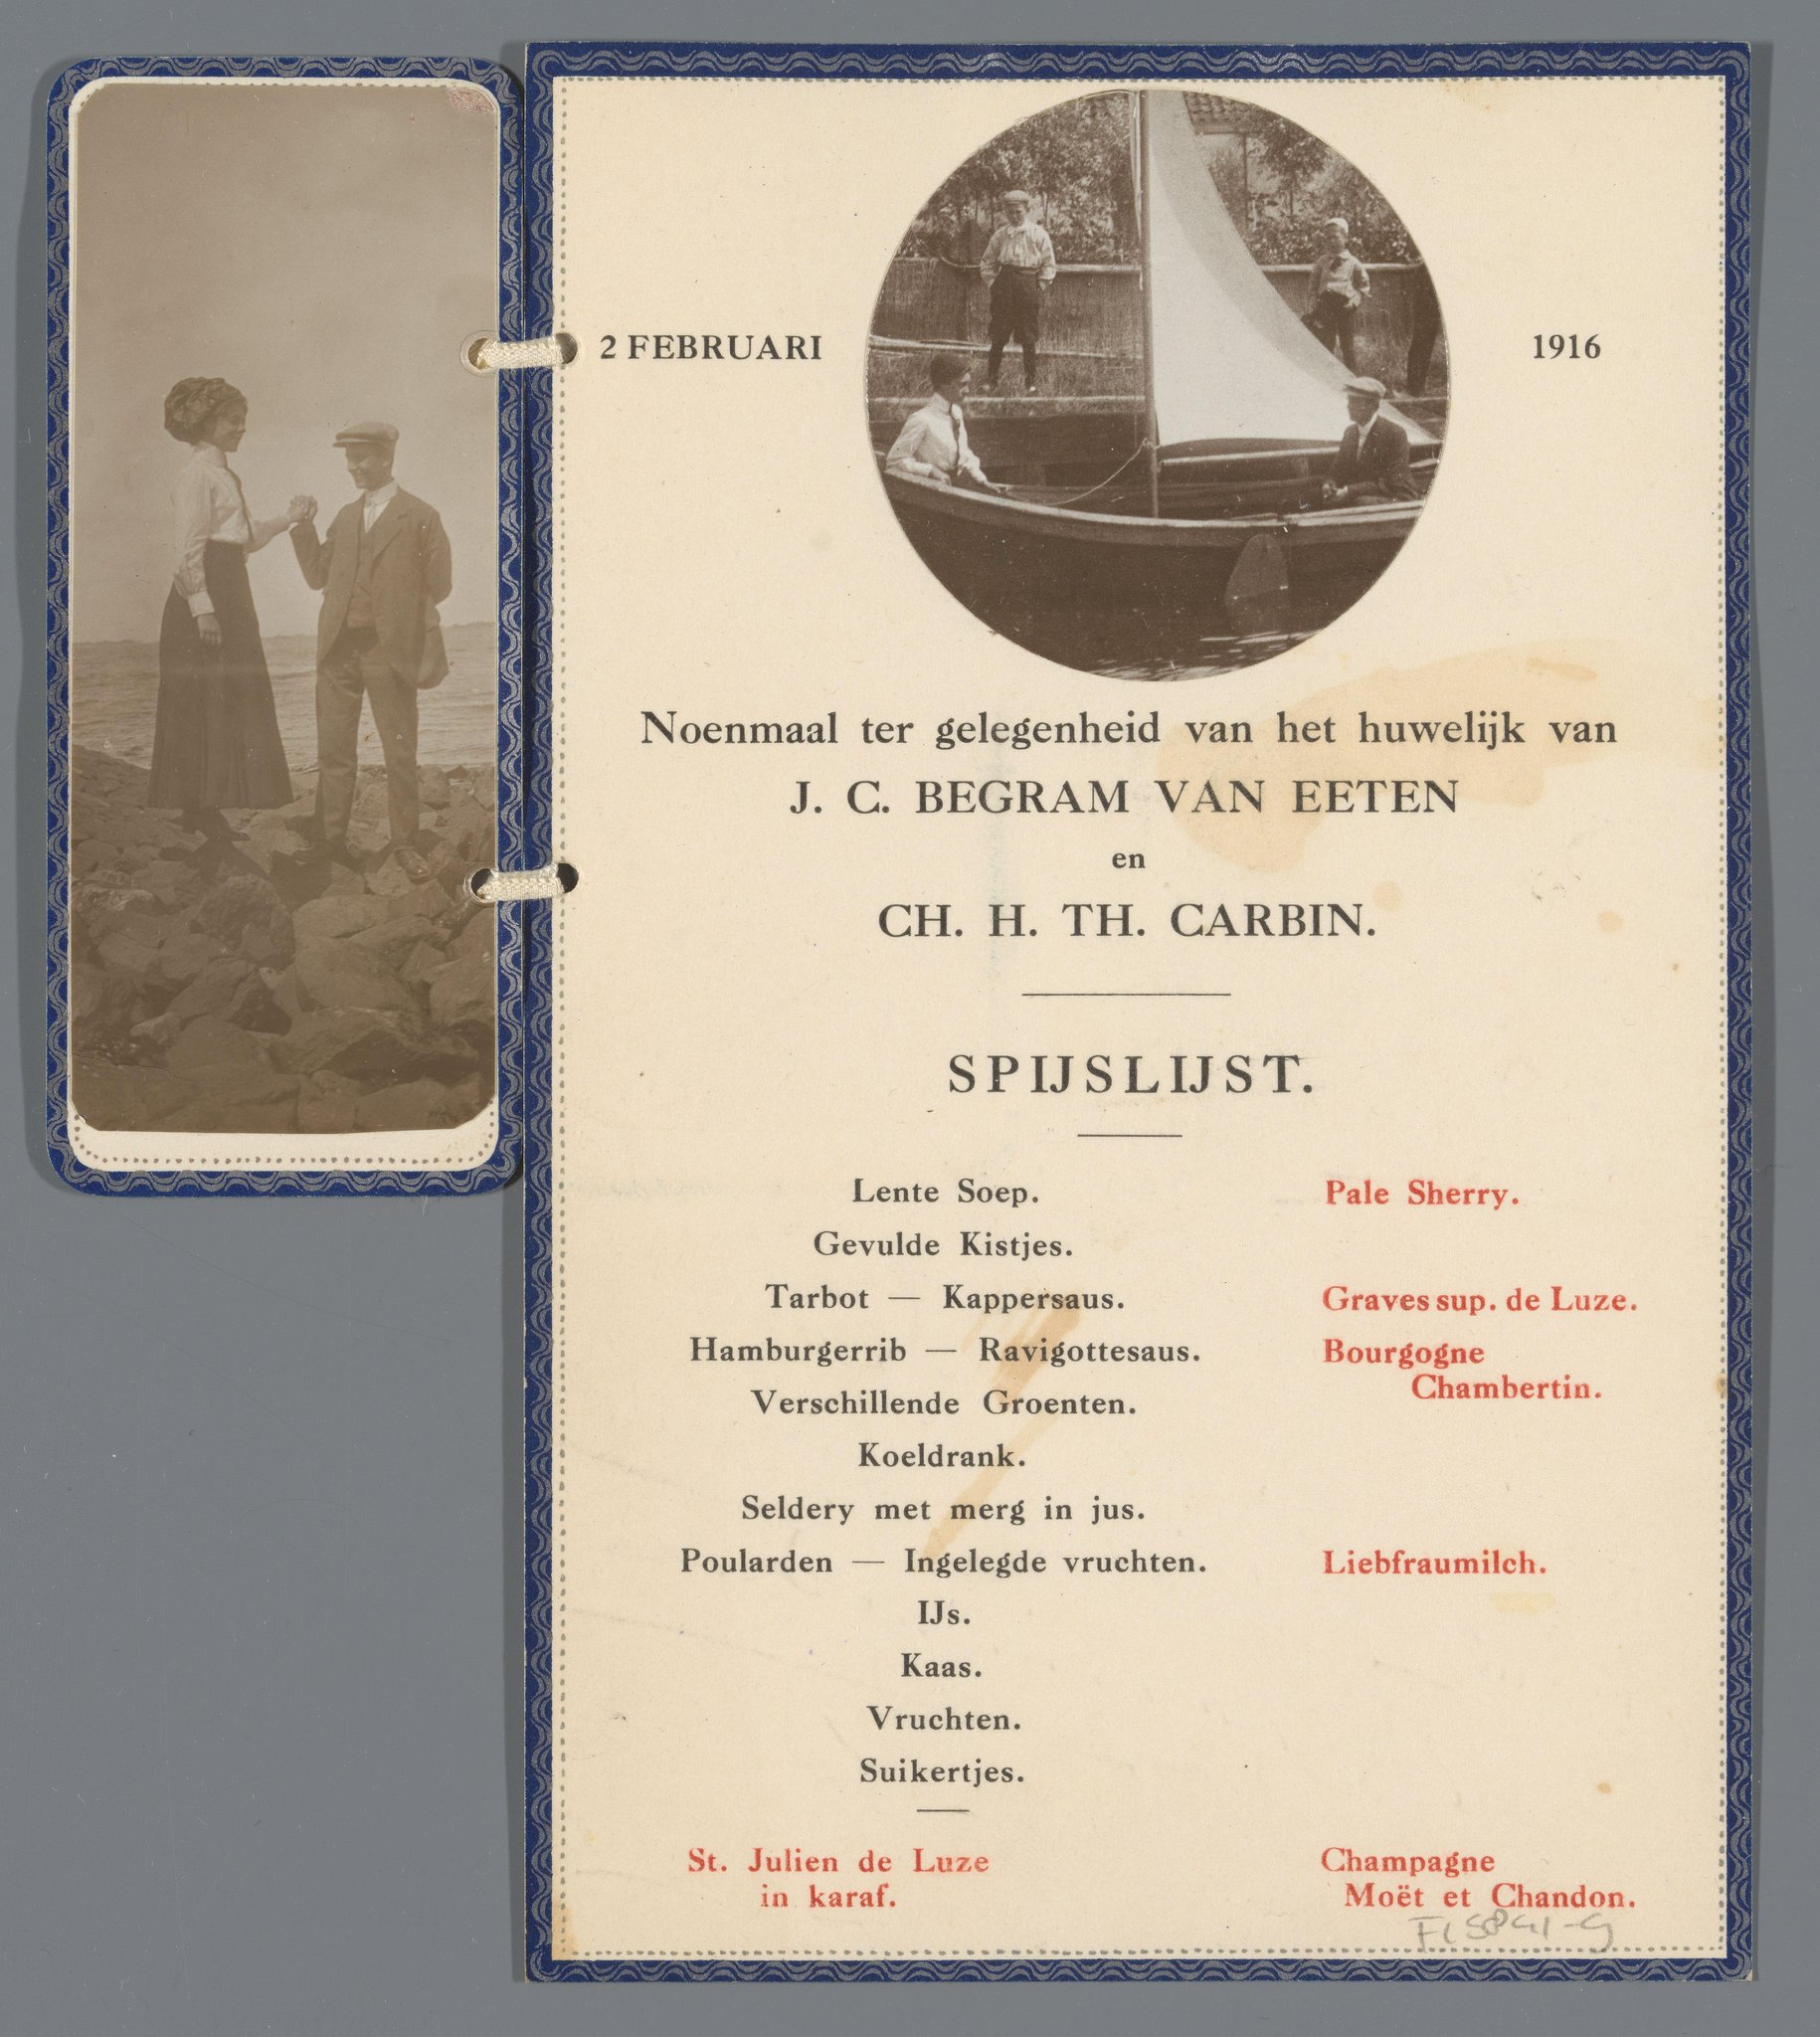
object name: photograph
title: Menukaart van de bruid voor het diner ter ere van het huwelijk tussen J.C. Begram van Eeten en Ch.H.Th. Carbin; met portretten van het paar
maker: Anonymous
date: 1916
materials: paper, pencil, textile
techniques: letterpress printing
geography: netherlands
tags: amsterdam, engineer, sailing-ship, sailing-boat, (civil) marriage ceremonies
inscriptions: inscription: ‘Noenmaal ter gelegenheid van het huwelijk van/ J.C. Begram van Eeten/ en/ Ch. H. Th. Carbin./ Spijslijst. (...)’, signature: ‘(...)’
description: Op de achterzijde handtekeningen van de gasten.